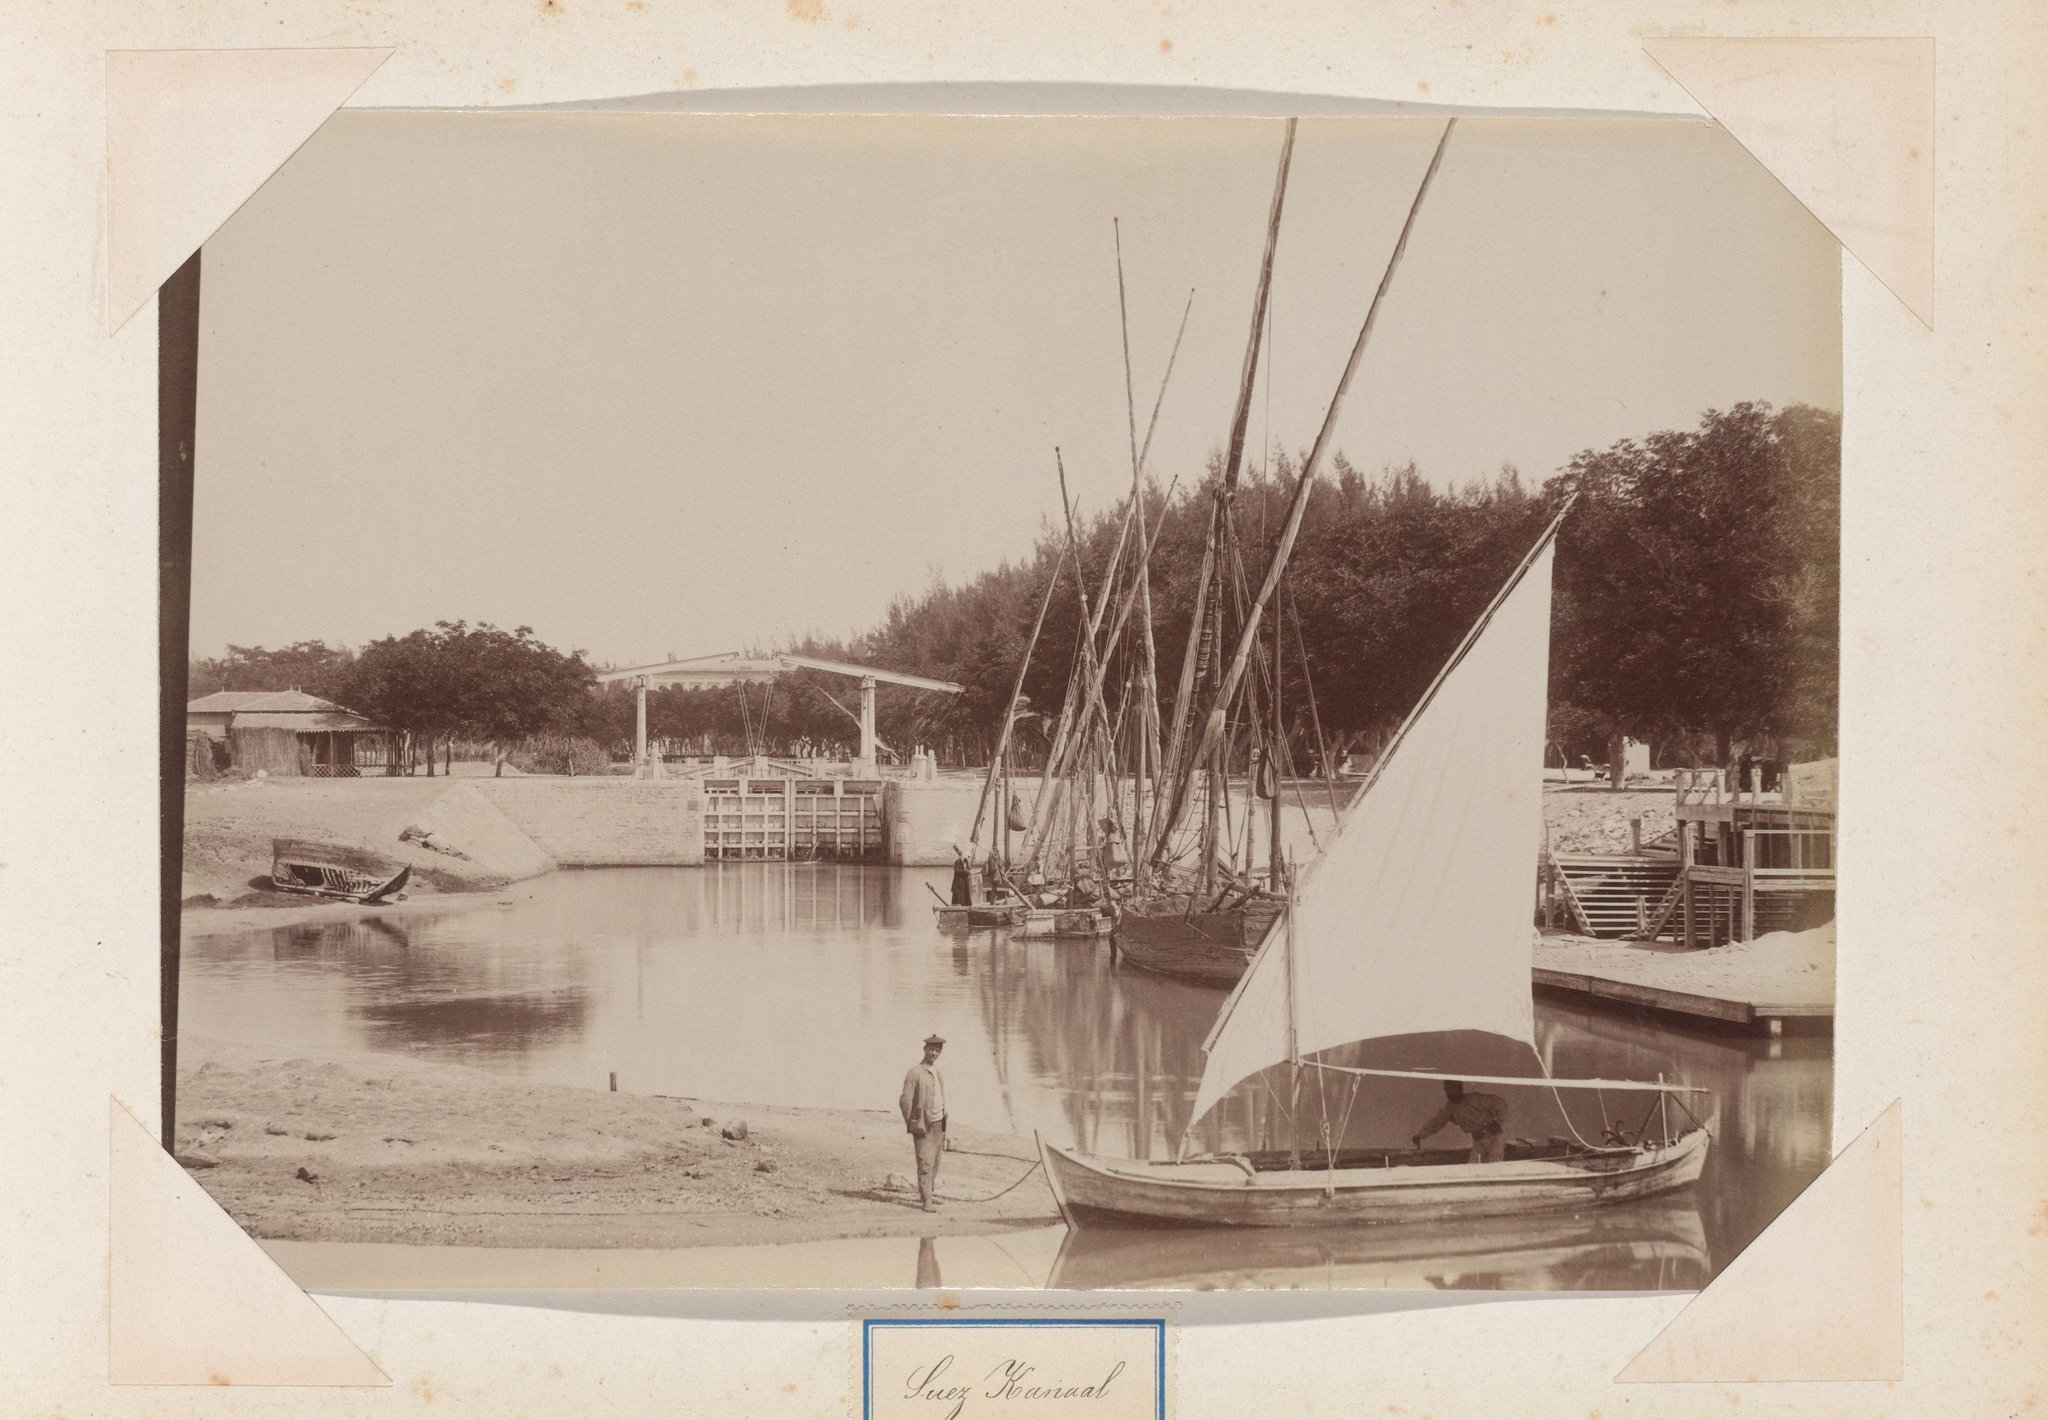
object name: photograph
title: Zeilschepen bij een sluis van het Suezkanaal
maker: Anonymous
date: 1870-1890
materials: paper, photographic support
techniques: albumen print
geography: suez canal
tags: canal, sluice, weir (+ landscape with figures, staffage)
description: Onderdeel van Album met 191 foto's van een reis naar en door Zuid-Afrika.